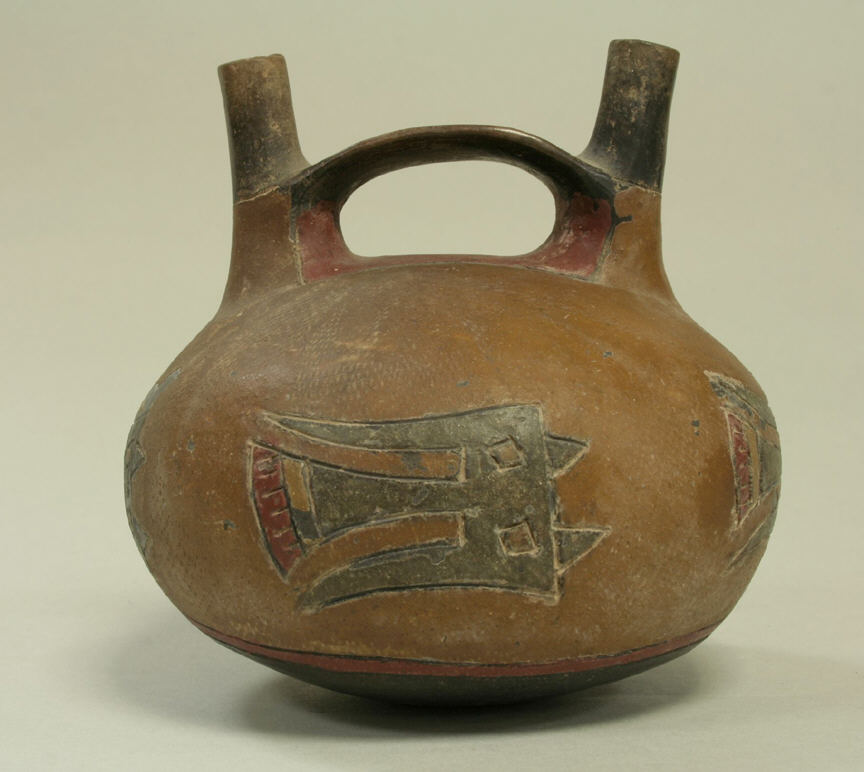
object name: bottle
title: Double spout and bridge bottle with birds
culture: paracas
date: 400-201 BCE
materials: ceramic, pigment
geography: peru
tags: birds